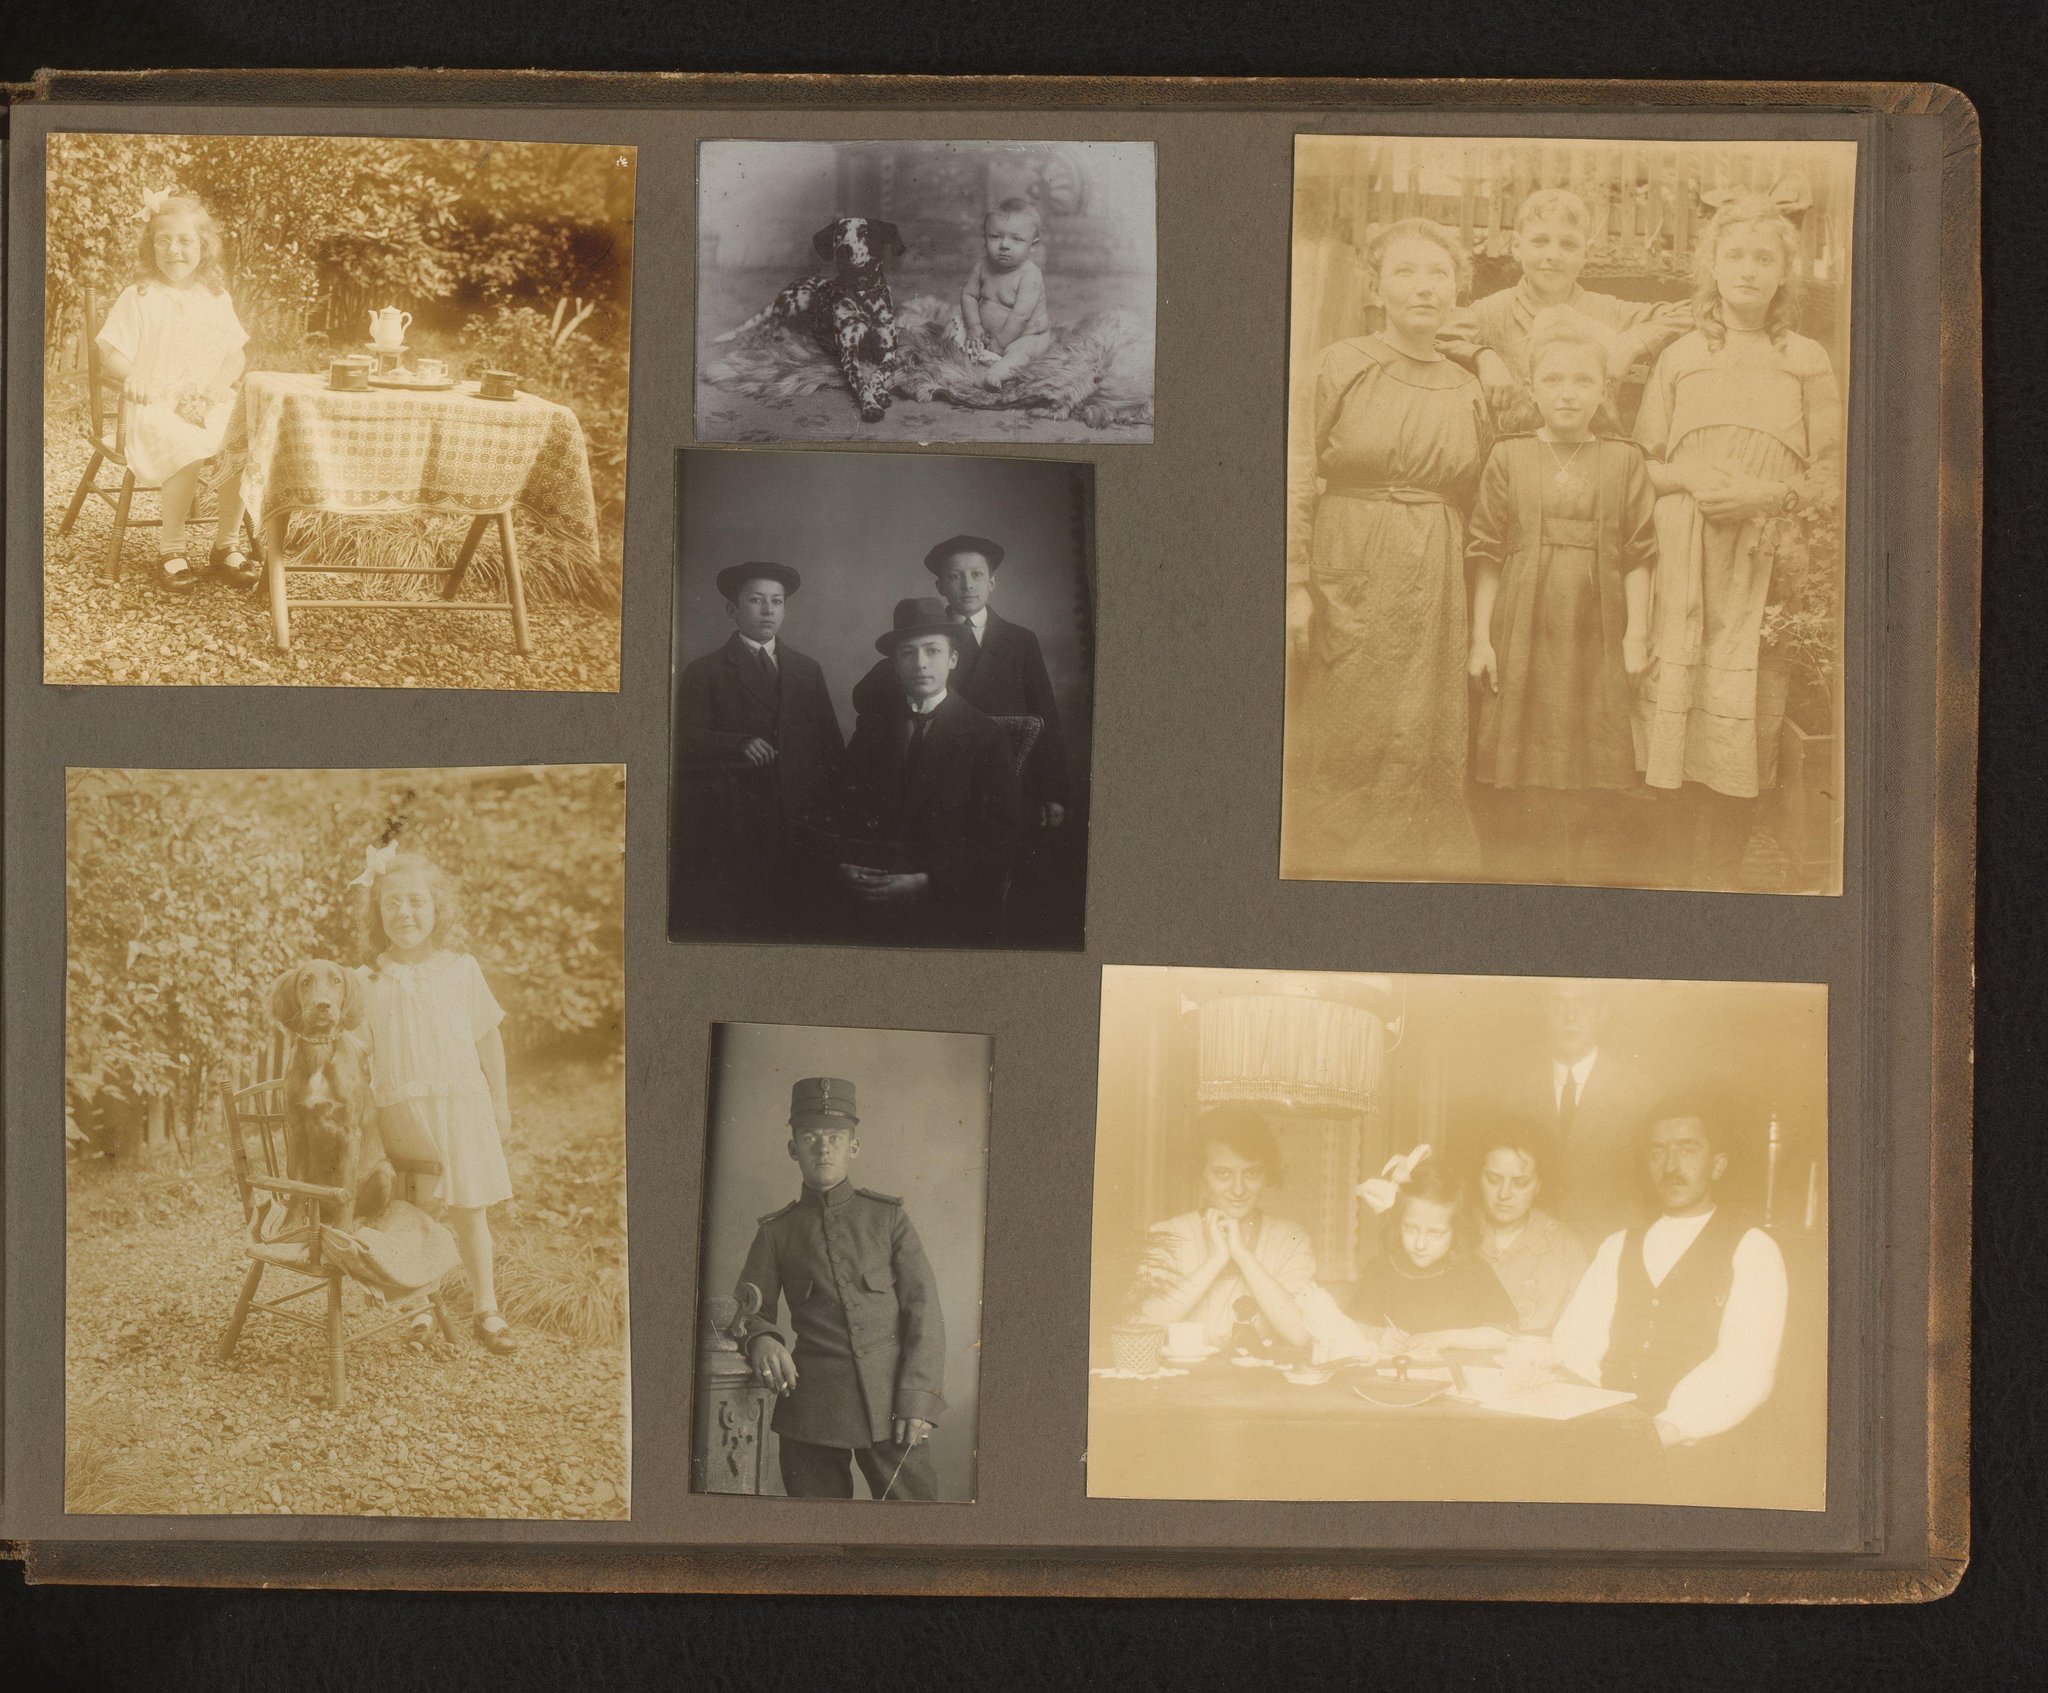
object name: photograph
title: Portretten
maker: Anonymous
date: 1900-1950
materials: photographic support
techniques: gelatin silver print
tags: adult woman, adult man, child, historical persons, youth, adolescent, girl (child between toddler and youth), (military) uniforms, dog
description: Twee portretten van een meisje in een tuin, waarvan een met hond, een baby met hond, groepsportretten van jonge mannen, jonge vrouwen en een van mannen, vrouwen en een meisje. Deze pagina maakt deel uit van een album.